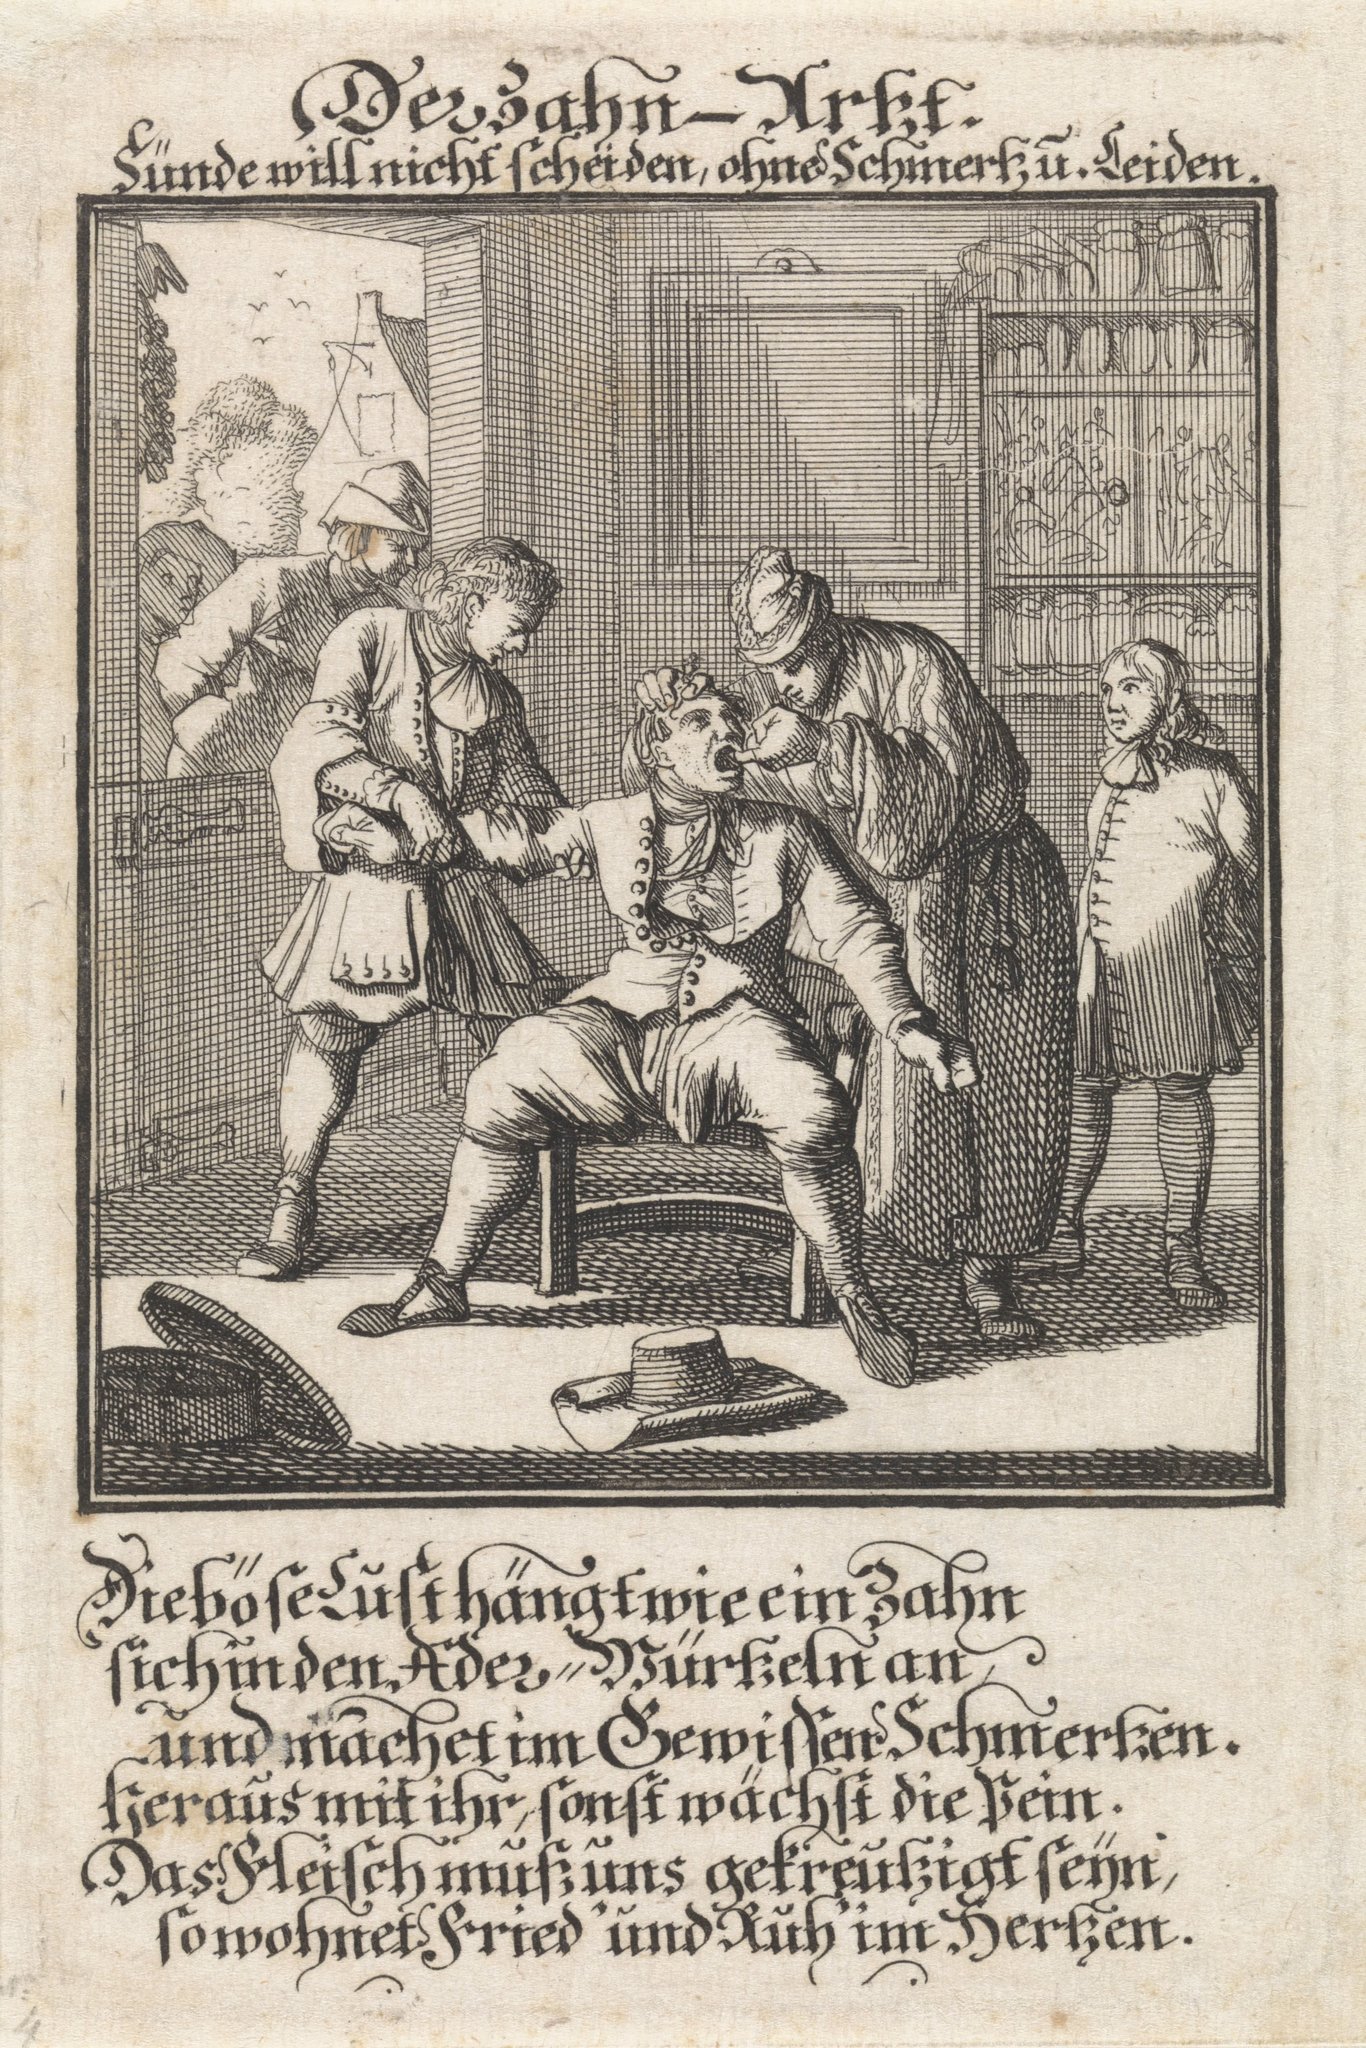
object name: book illustration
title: Tandarts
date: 1698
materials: paper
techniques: etching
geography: amsterdam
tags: (barber as) dentist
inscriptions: number: ‘4’, collector's mark: Lugt 2228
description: Illustratie uit: Weigel, Christoff. Abbildung Der Gemein-Nützlichen Haupt-Stände Von denen Regenten Und ihren So in Friedens- als Kriegs-Zeiten zugeordneten Bedienten an, biß auf alle Künstler Und Handwercker. Regenspurg 1698, p. 149.